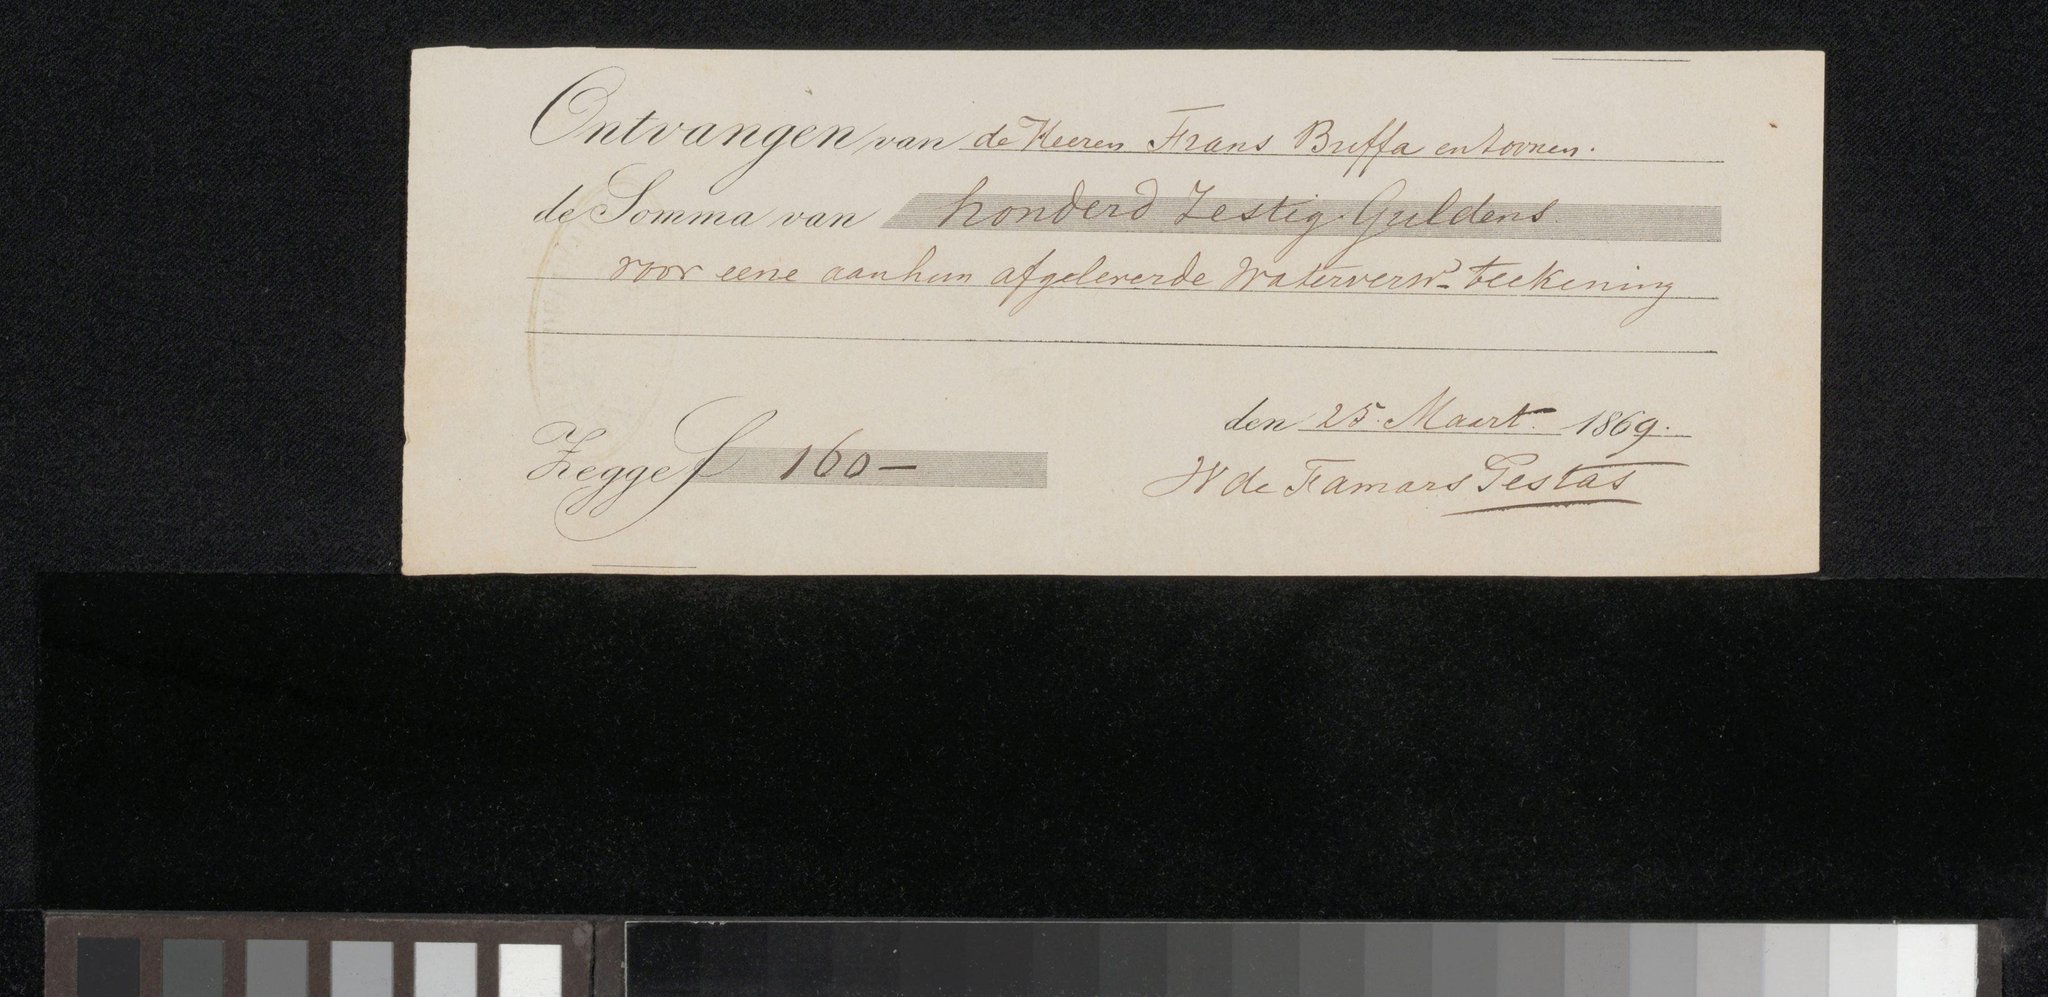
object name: ontvangstbewijs, kwitantie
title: Kwitantie voor Willem de Famars Testas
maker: willem de famars testas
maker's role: draughtsman, painter, print maker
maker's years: 1834-1896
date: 1869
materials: ink, paper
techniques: pen, printing, writing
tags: drawing, money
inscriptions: collector's mark: Lugt 2233, stamp: ‘EXPEDITIE VAN/ C.J. VAN DEVENTER./ No’